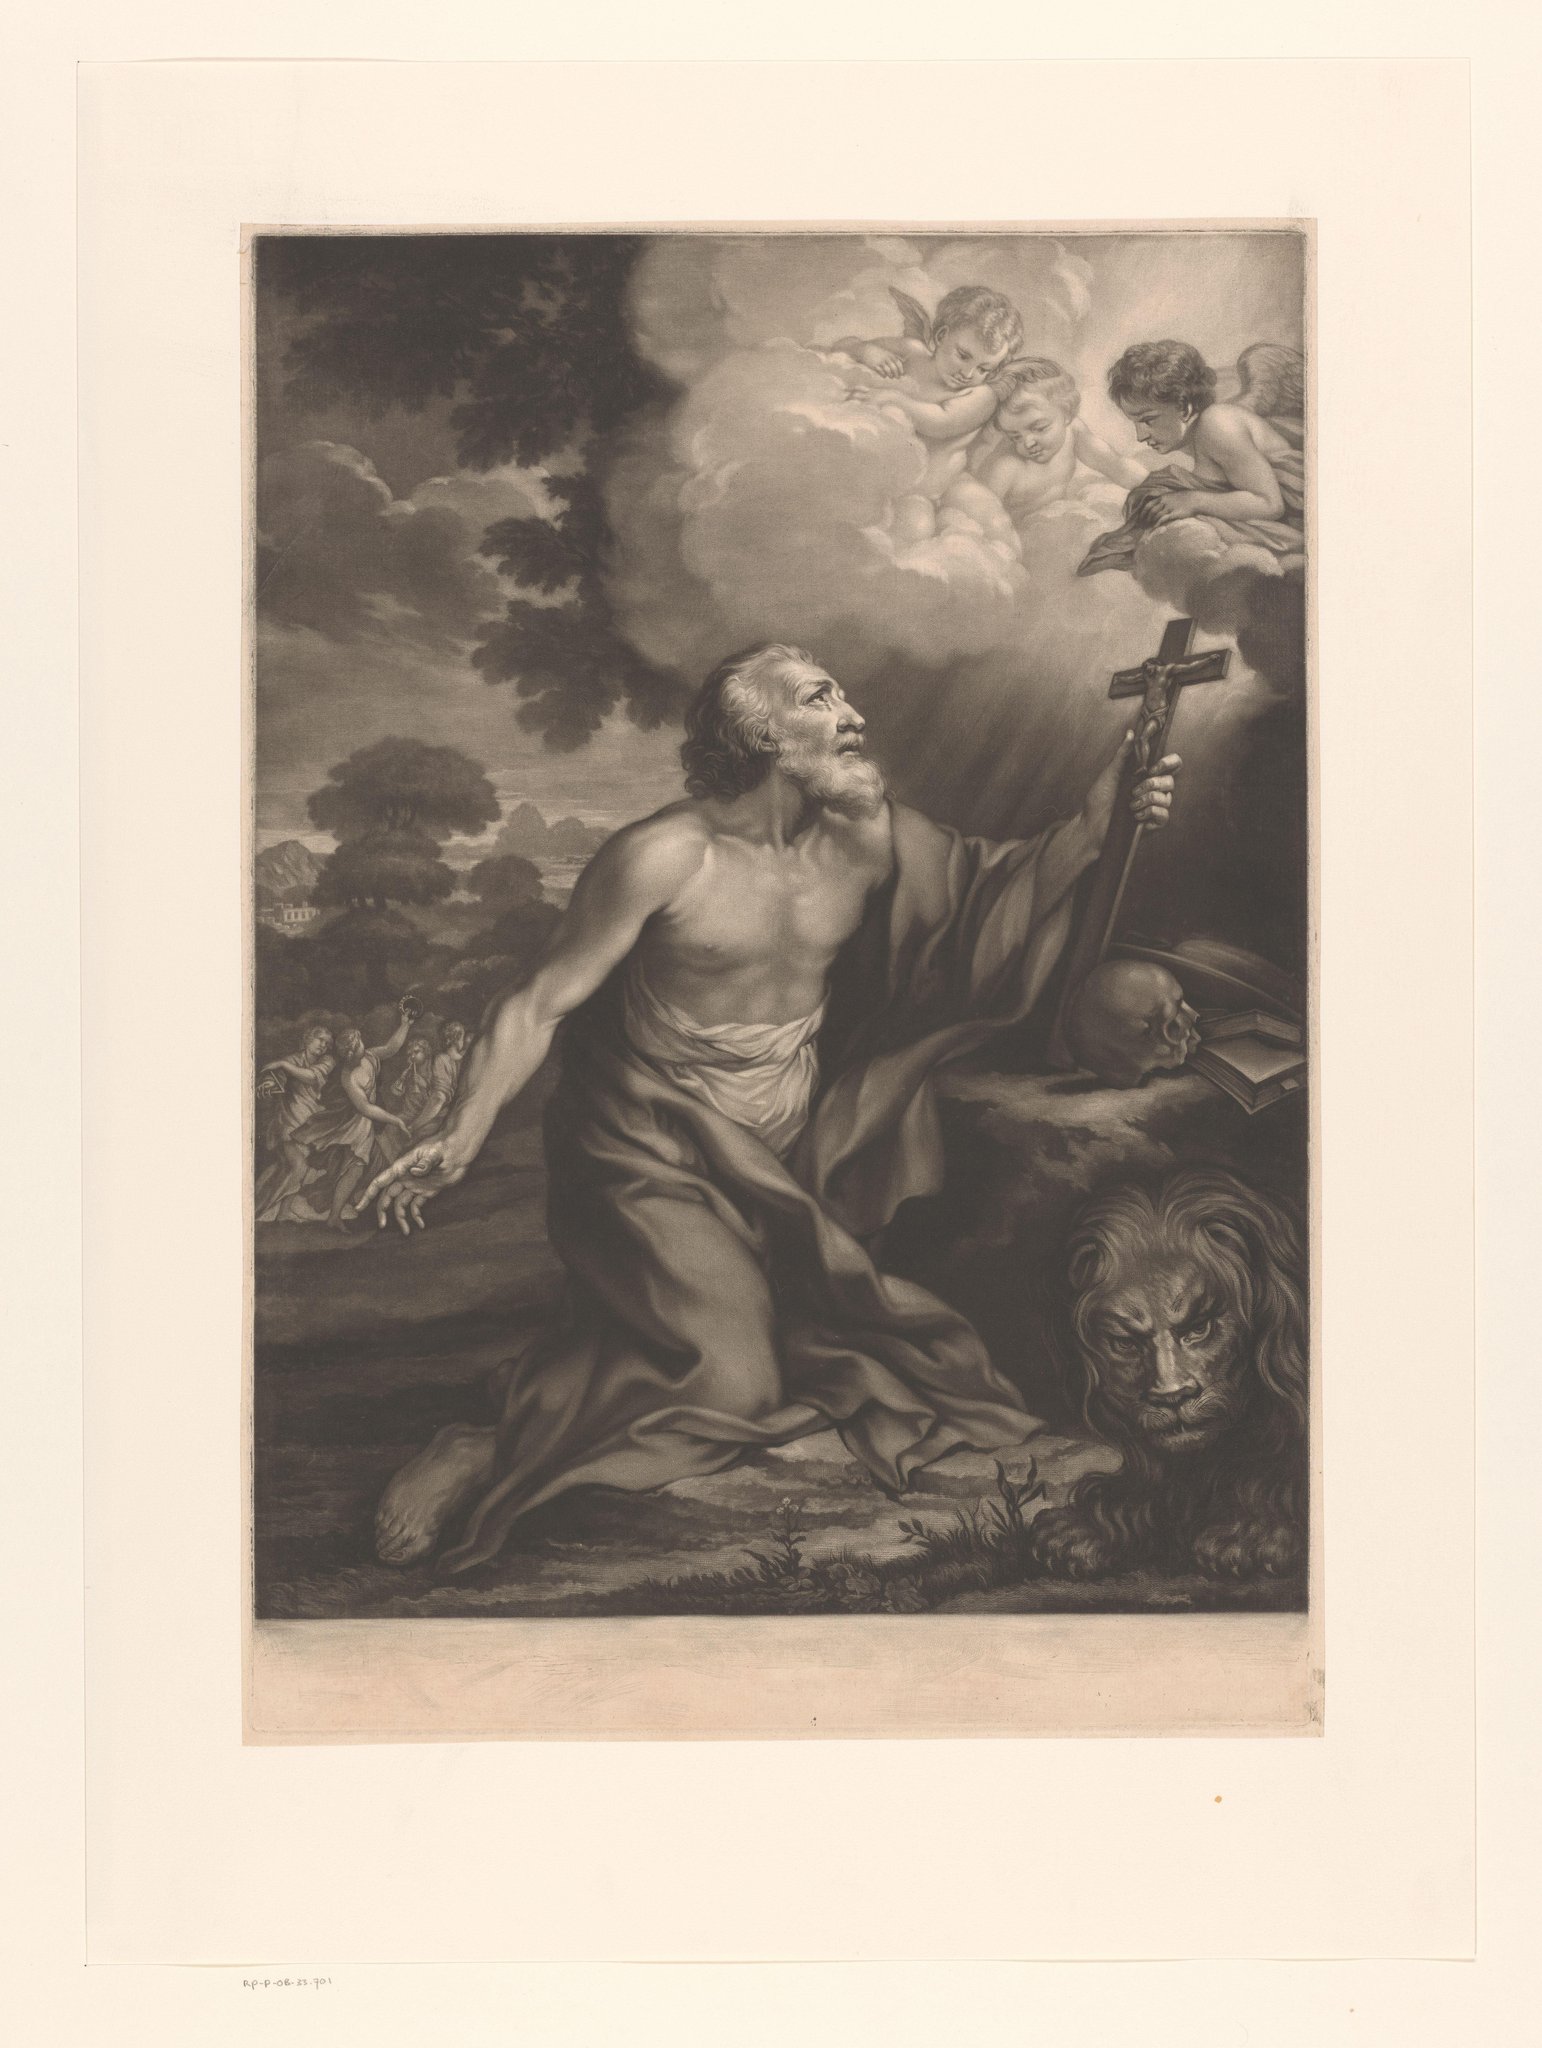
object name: print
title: Heilige Hieronymus bij crucifix, boek en schedel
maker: james mcardell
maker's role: print maker, publisher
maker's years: 1728-1765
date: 1746-1765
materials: paper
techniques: etching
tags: personal devotion of st. jerome, st. jerome tempted by a dance of young girls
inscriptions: collector's mark: Lugt 240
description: Links op de achtergrond een groep dansende en musicerende figuren.